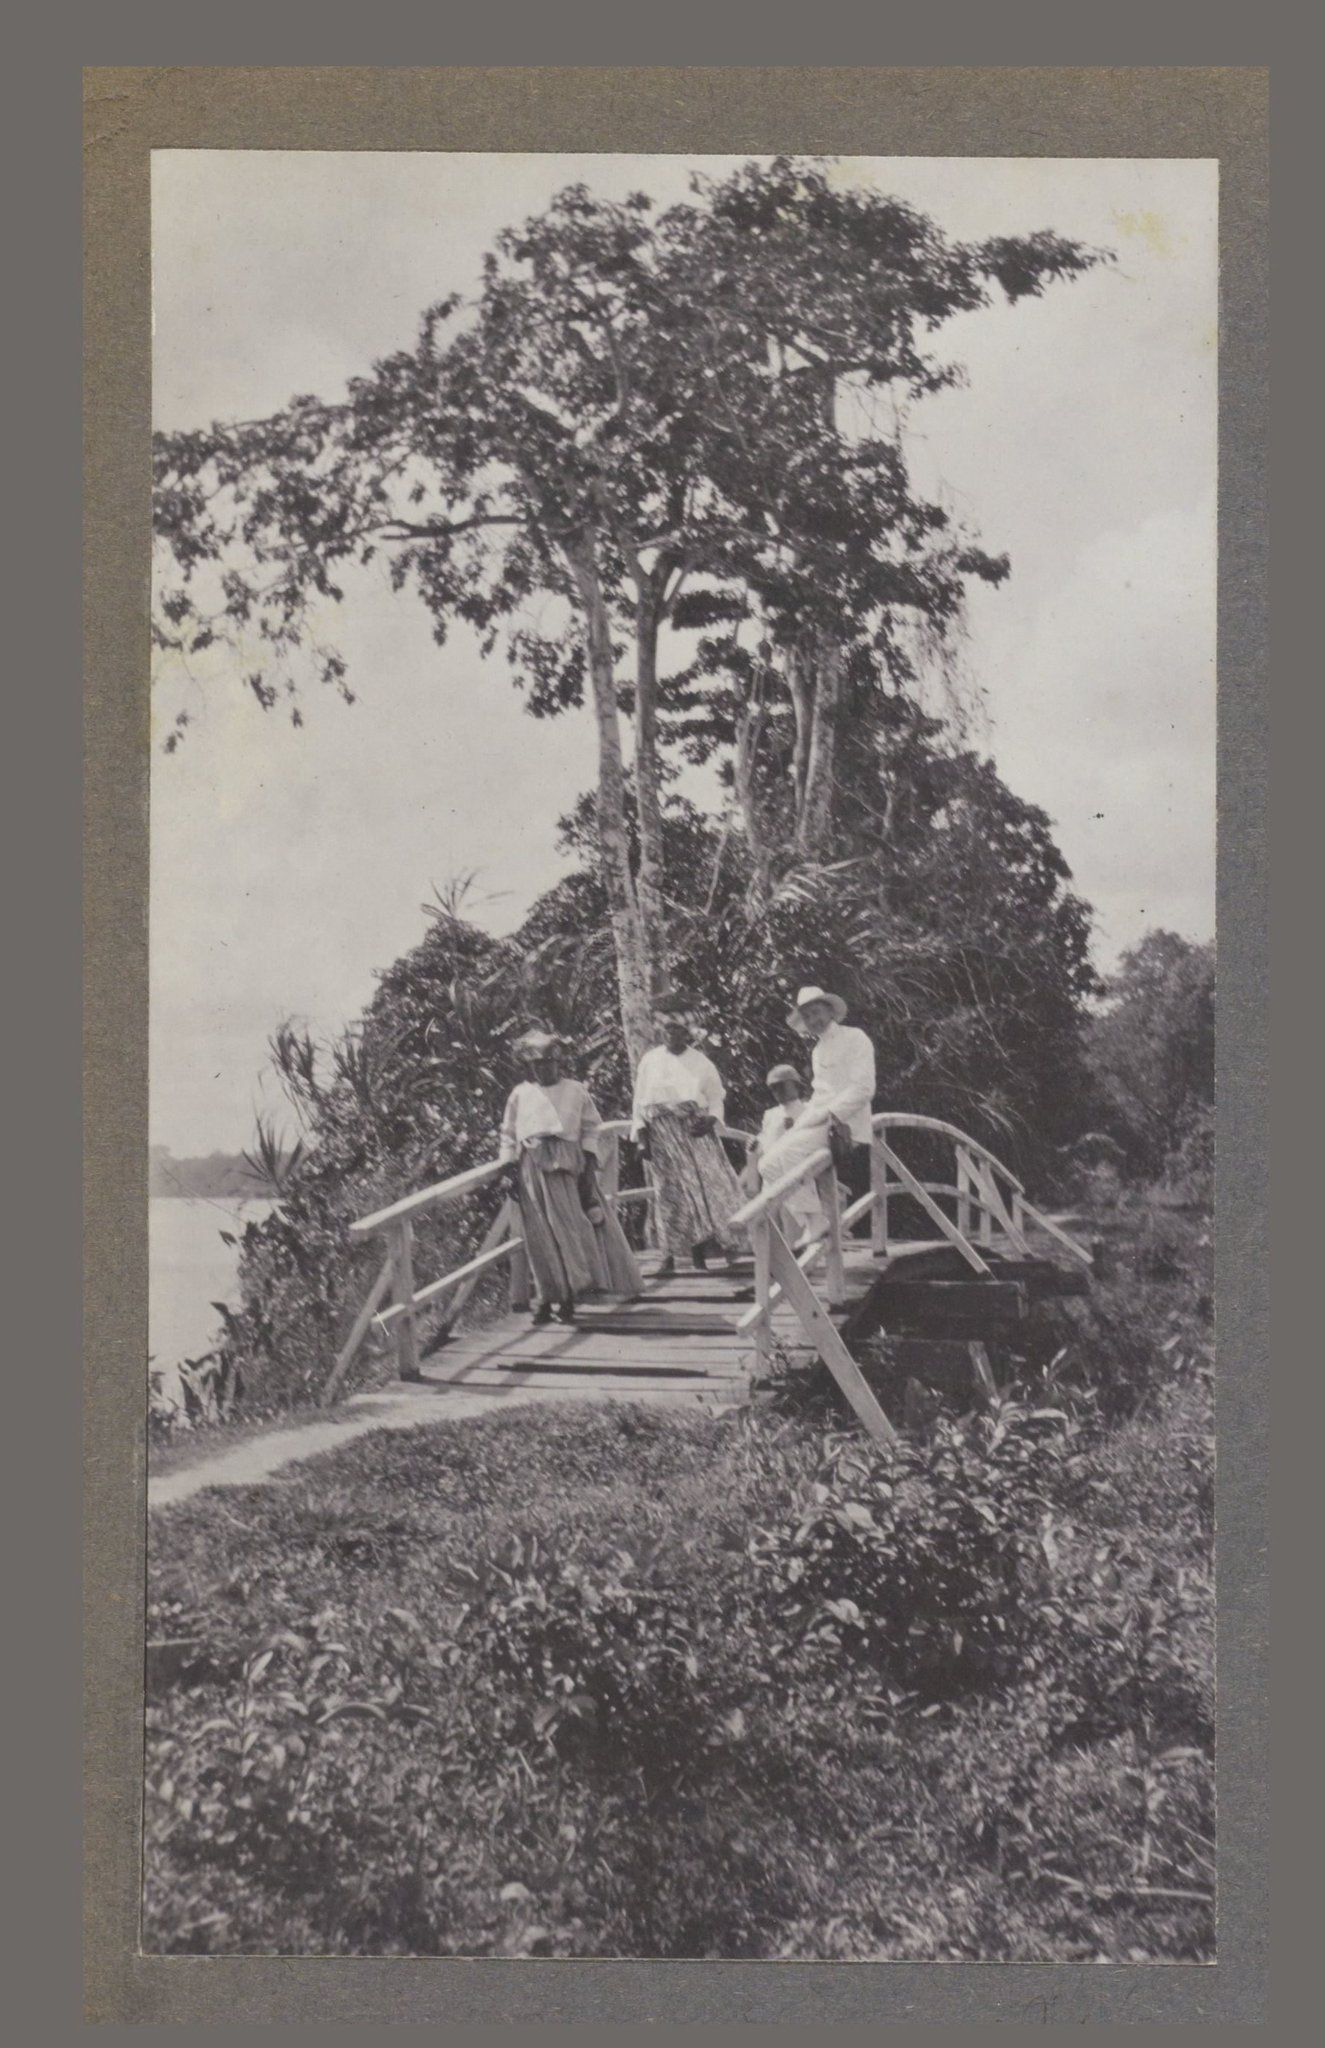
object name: photograph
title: Bij Groningen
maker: Anonymous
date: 1911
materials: photographic support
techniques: photography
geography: gröningen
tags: amsterdam, andries augustus boom, suriname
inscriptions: inscription: ‘Groningen’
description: Andries Boom en een andere man samen met twee Surinaamse vrouwen op een bruggetje bij Groningen. Onderdeel van het fotoalbum over het leven van de familie Gonggrijp in Suriname rond 1912.